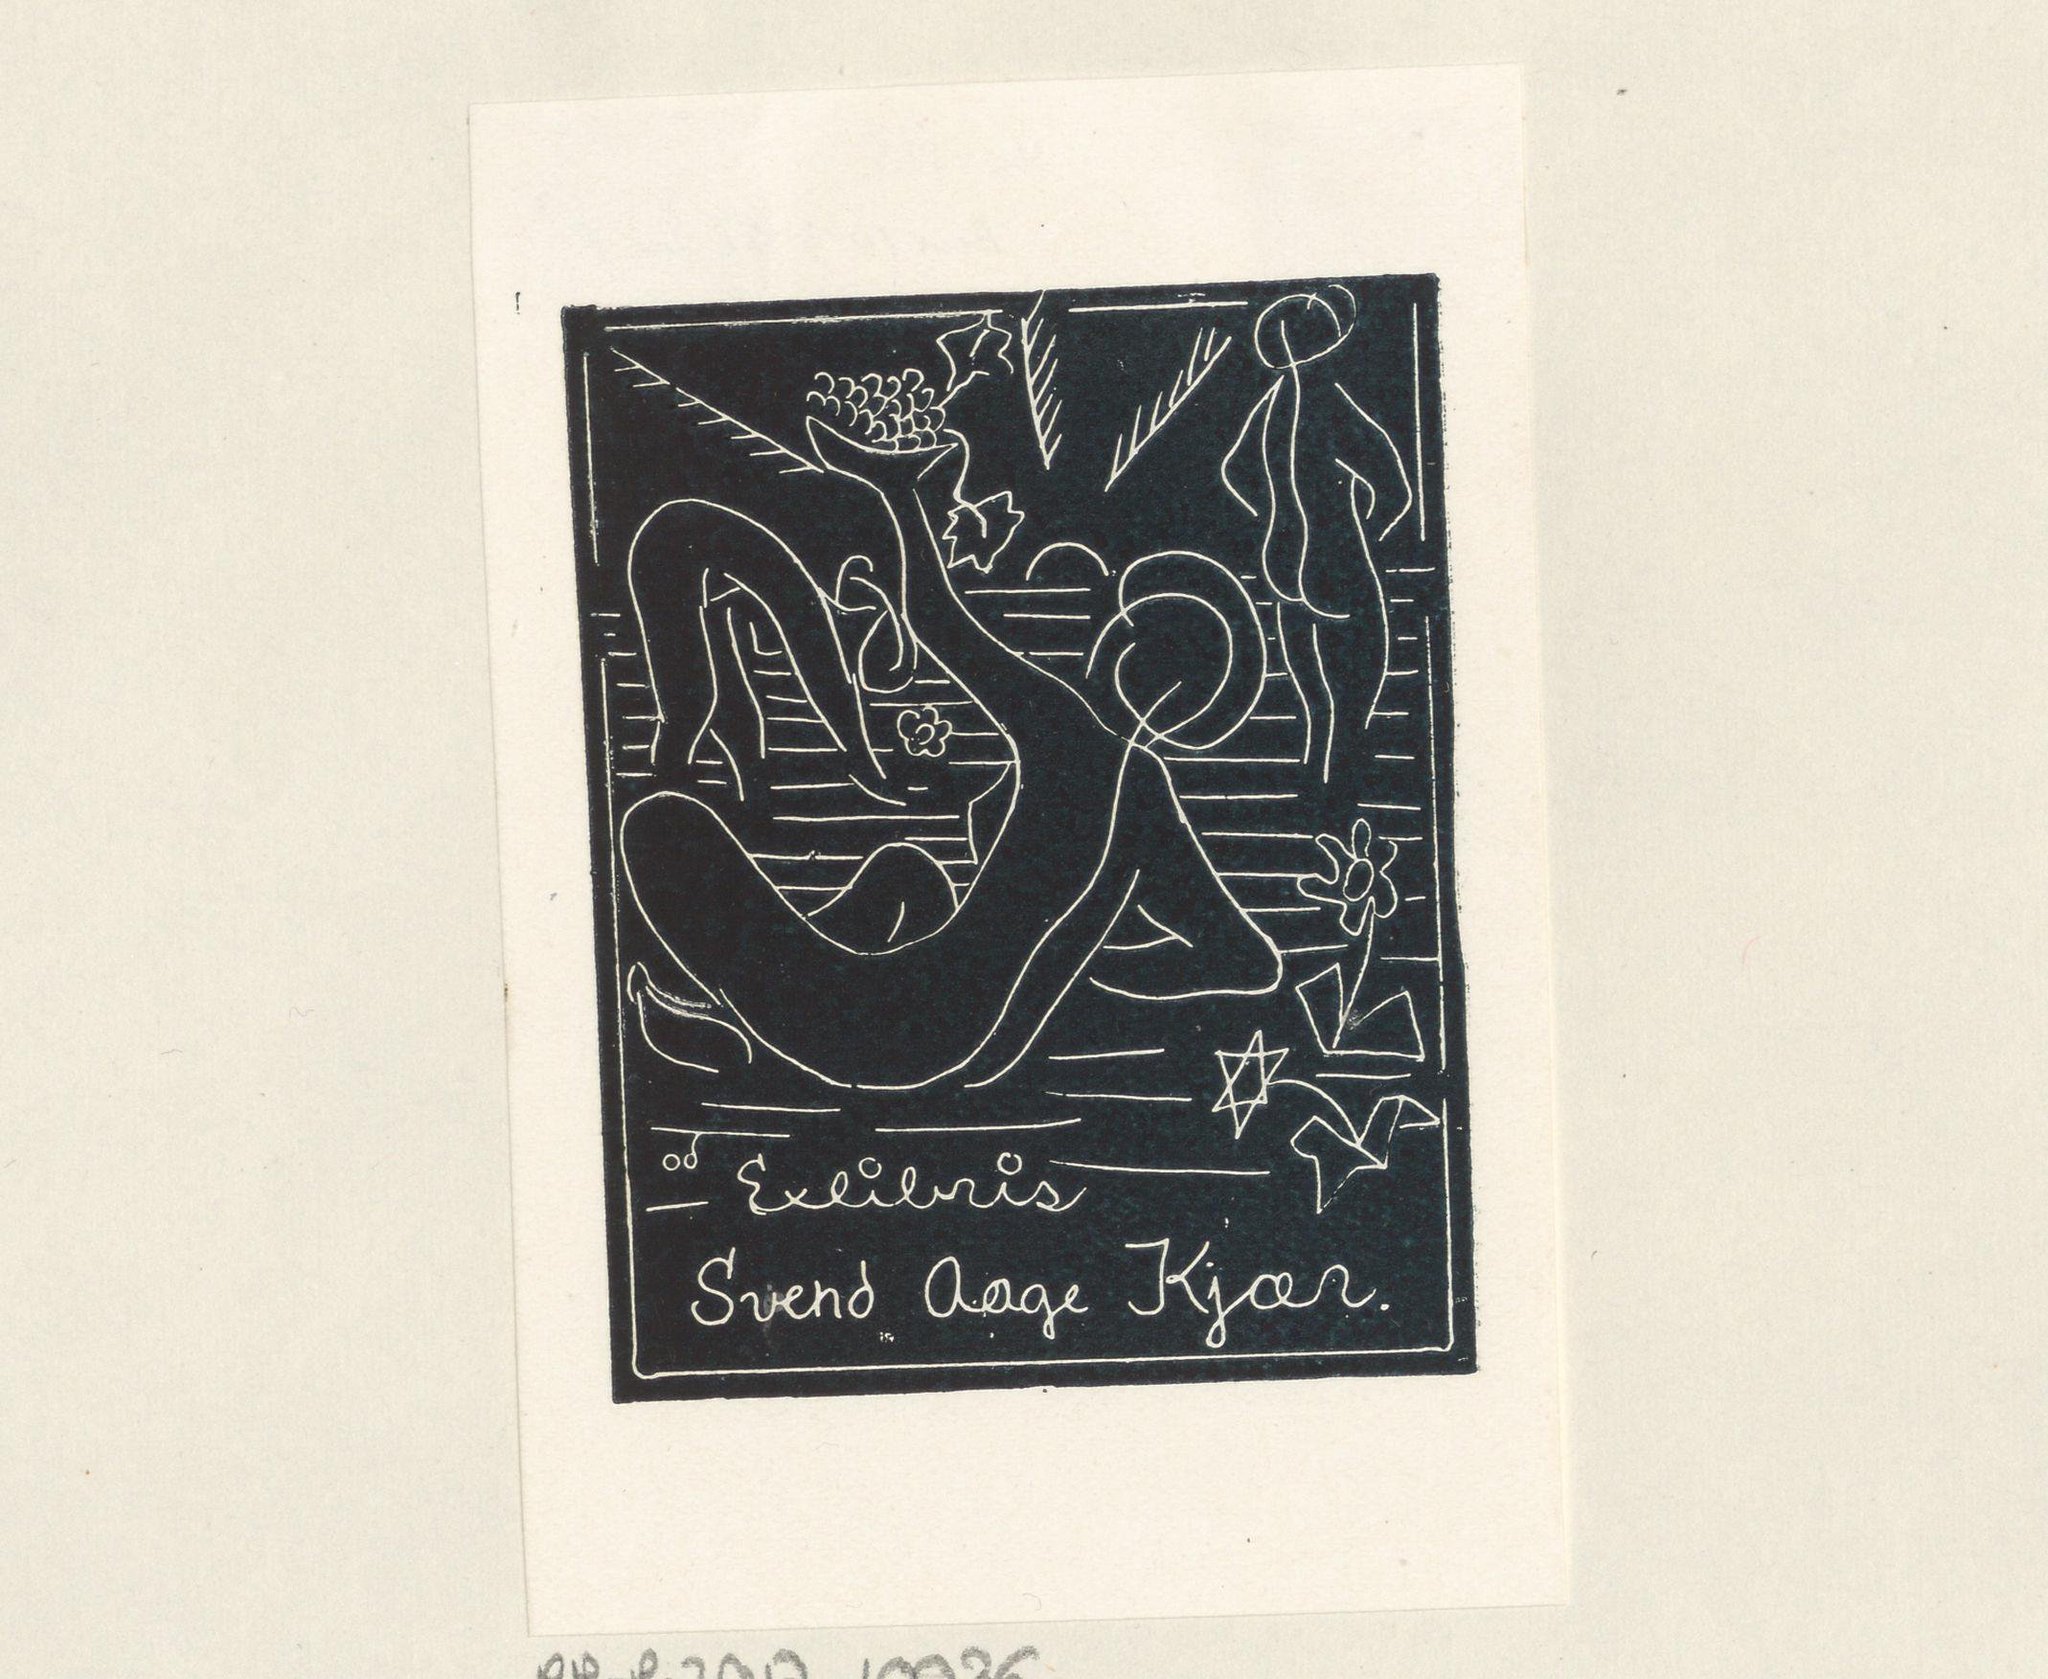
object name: bookplate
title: Ex libris van Svend Aage Kjær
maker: ole dich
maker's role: print maker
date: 1900-1999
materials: paper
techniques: linocut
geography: denmark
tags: woman (showing herself) undressed, quasi-nude, bunch of grapes